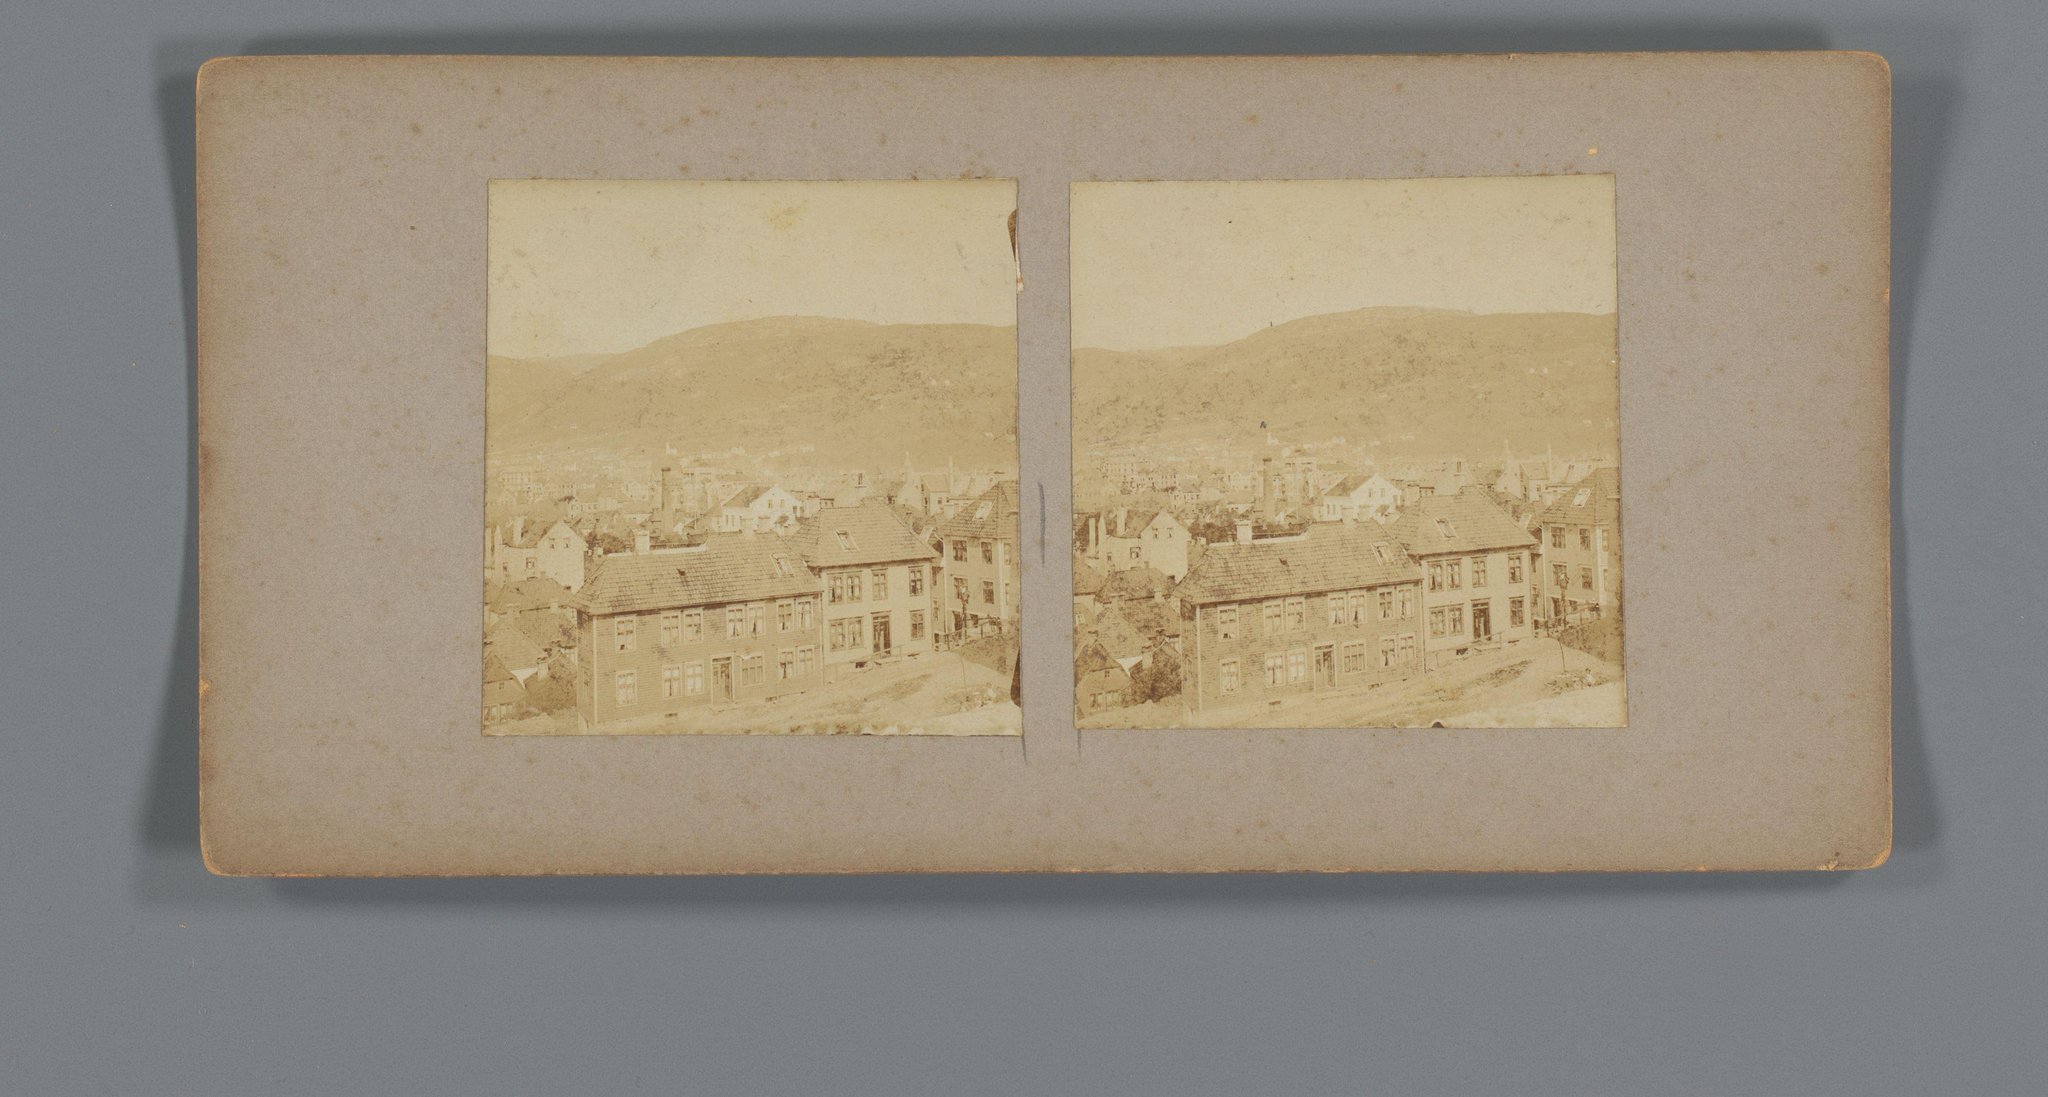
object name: stereograph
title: Bergen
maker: Anonymous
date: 1882-1890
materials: cardboard, photographic support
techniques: gelatin silver print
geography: bergen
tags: city-view in general; 'veduta'